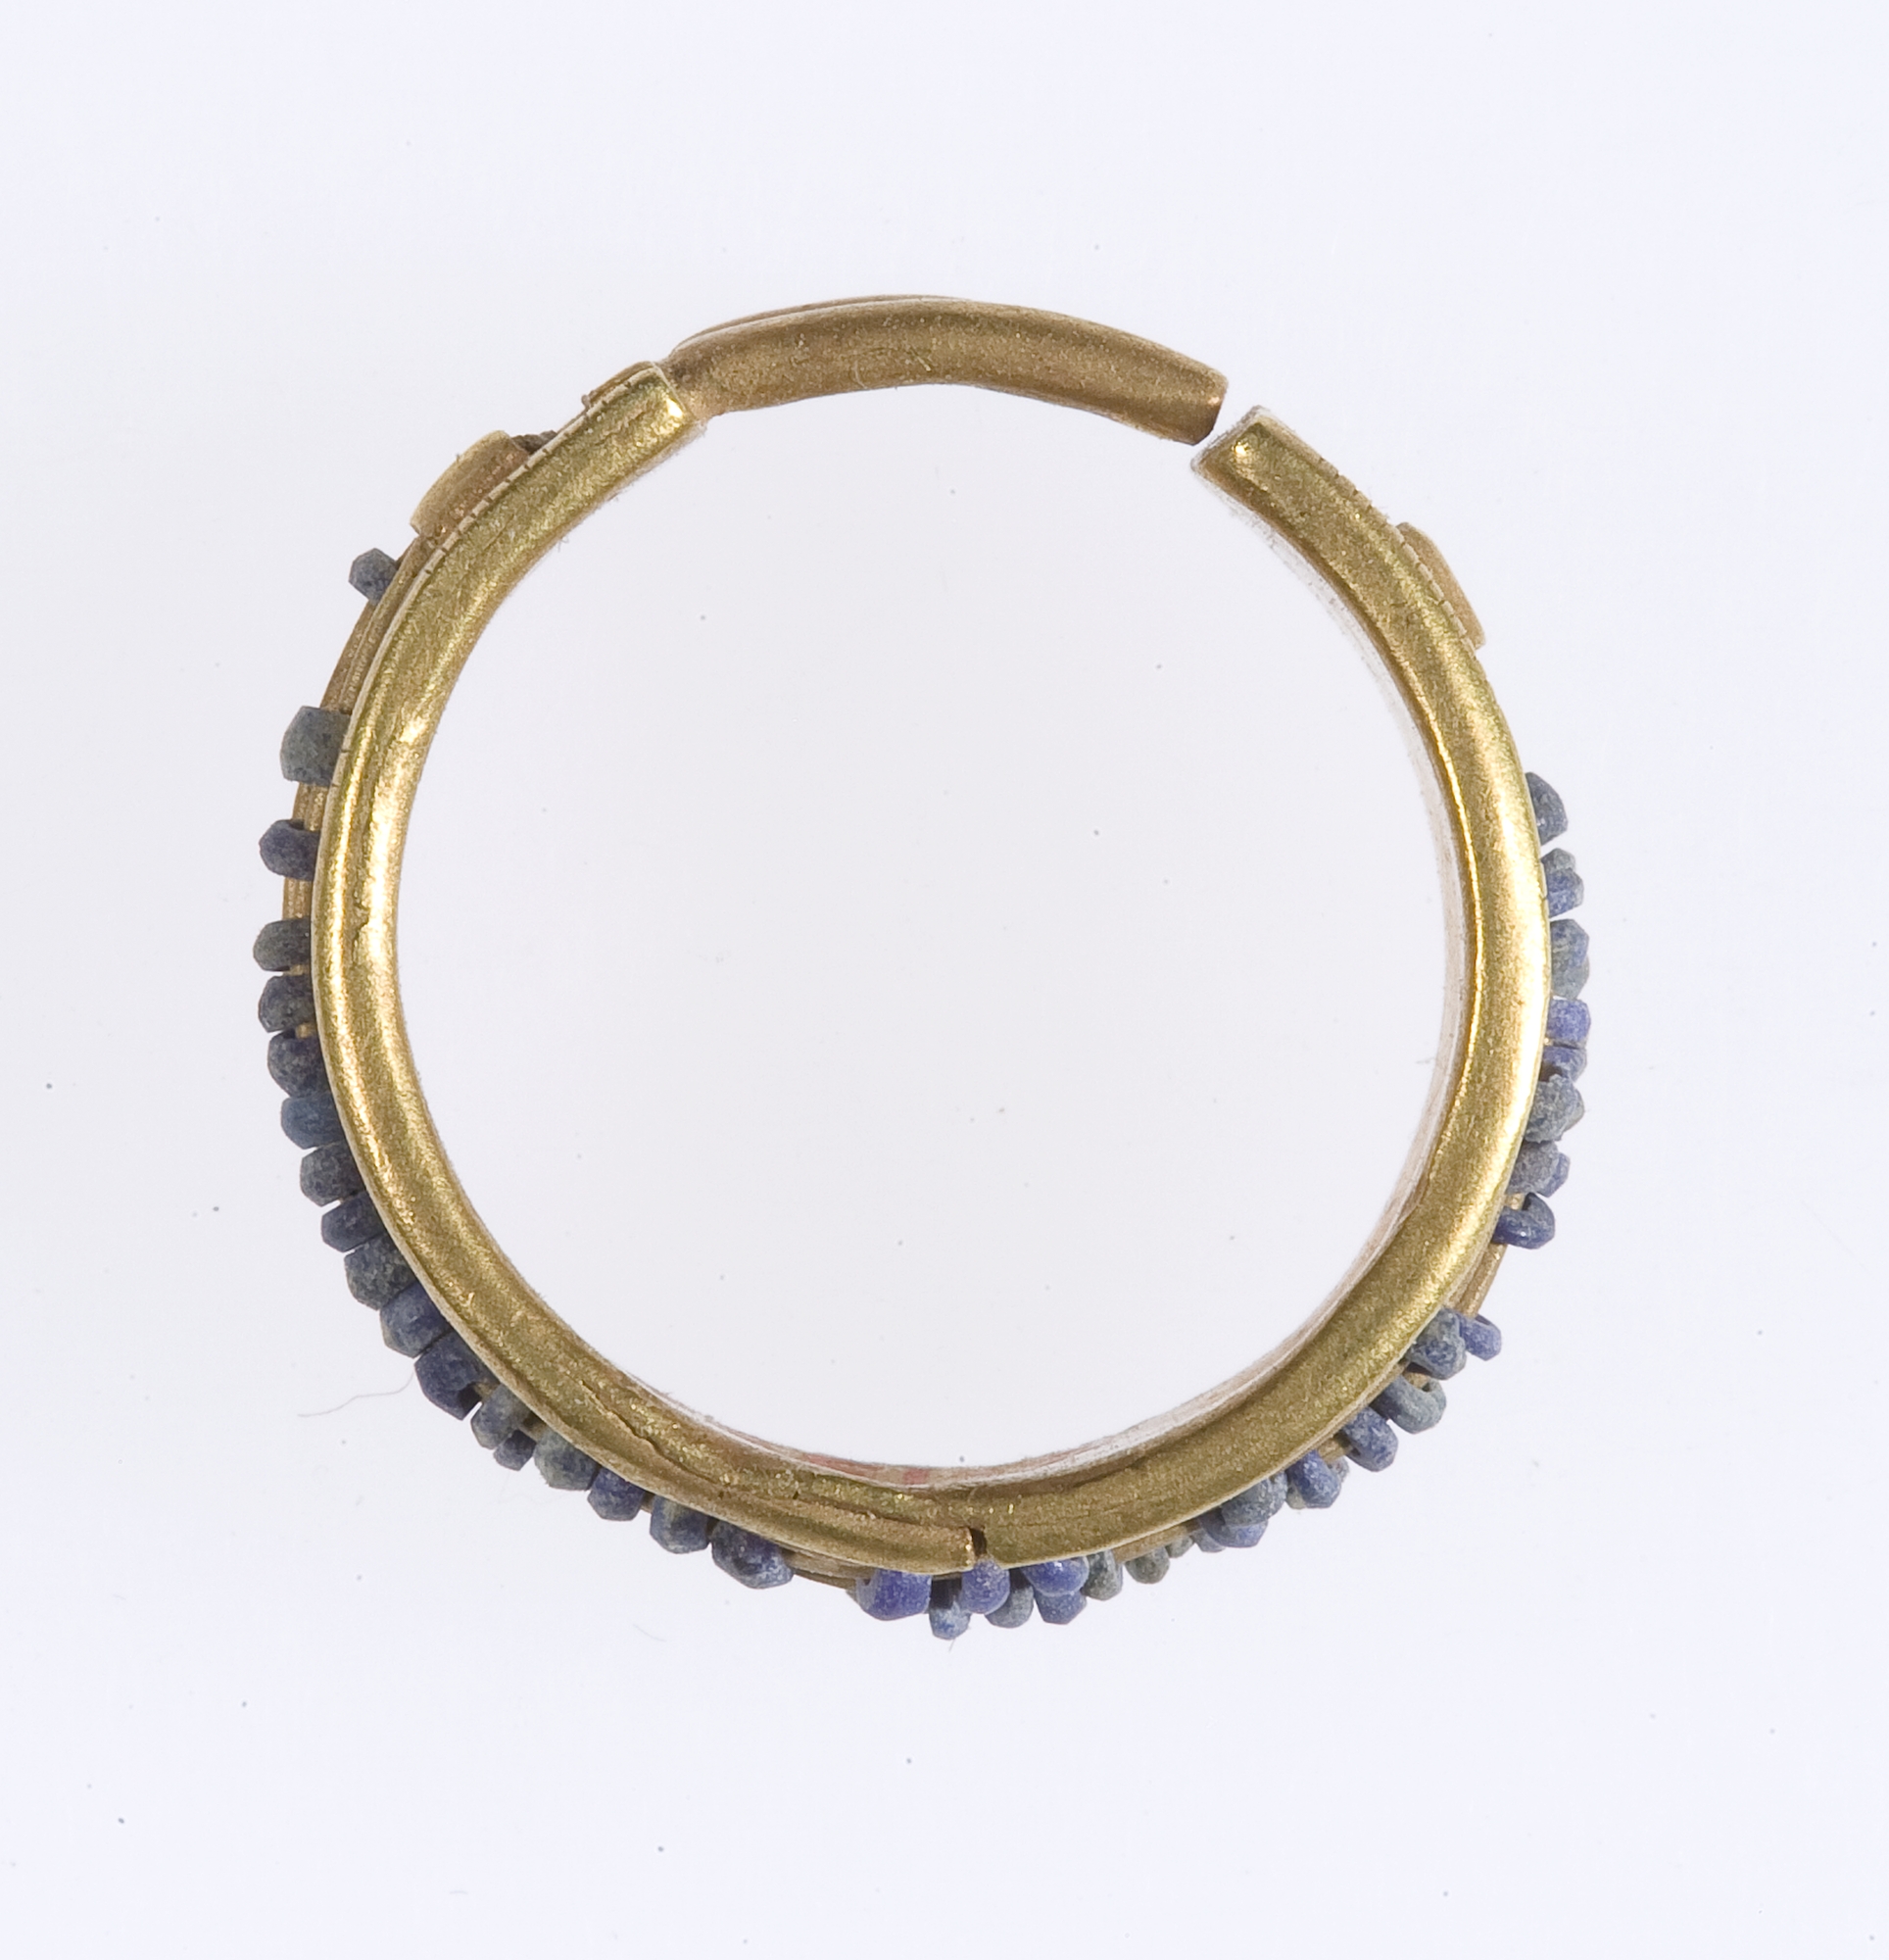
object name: earring, penannular, beaded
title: Beaded Penannular Earring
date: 1550-1425 BCE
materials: gold, lapis lazuli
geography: egypt